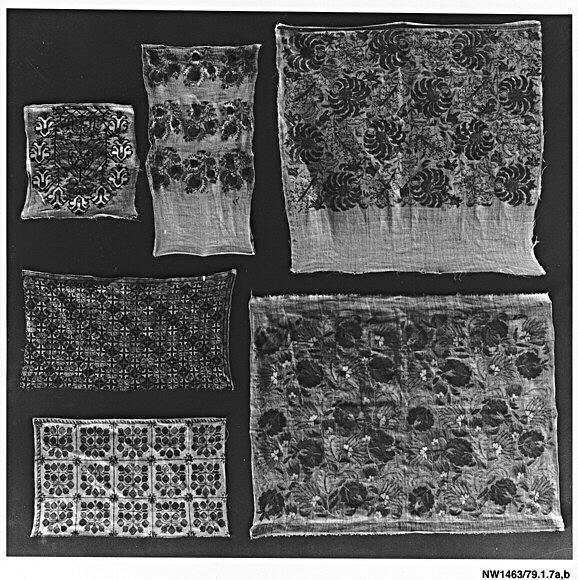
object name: towel end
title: Towel Ends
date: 1801-1833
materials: linen, metal thread, silk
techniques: embroidery, weave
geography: turkey